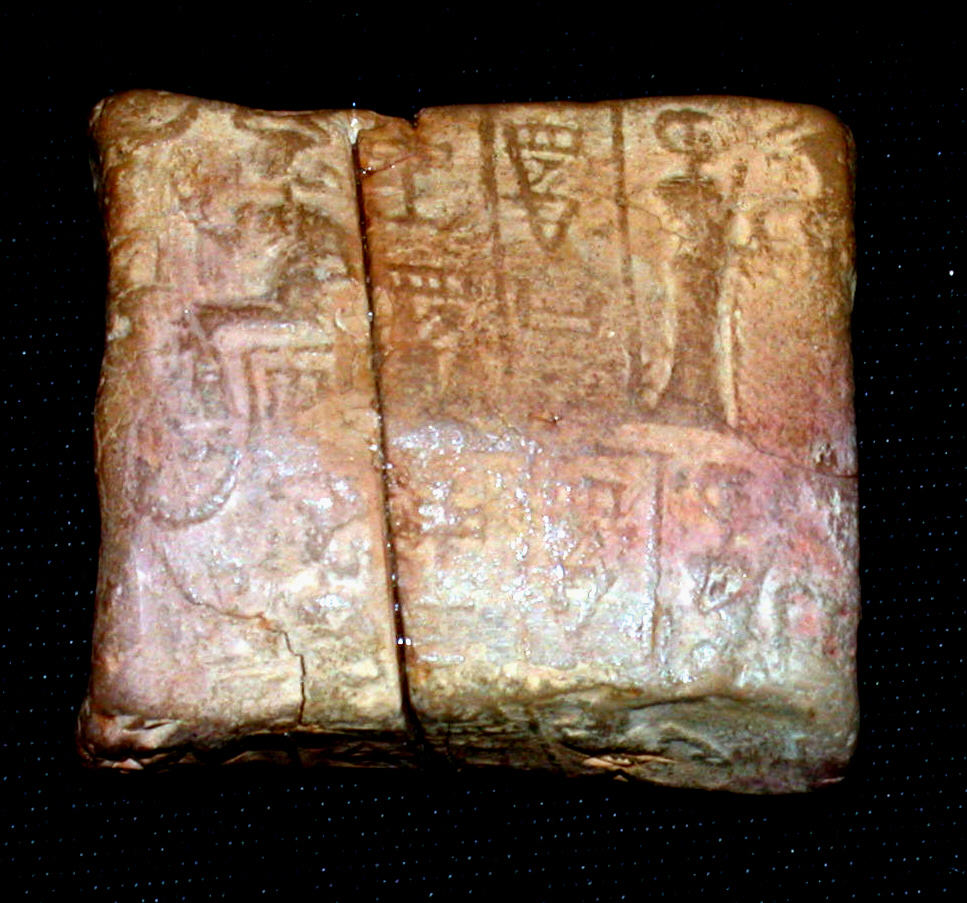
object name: cuneiform tablet case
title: Cuneiform tablet case impressed with cylinder seal, for cuneiform tablet 86.11.249a: receipt of a kid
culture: neo-sumerian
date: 2051 BCE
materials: clay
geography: mesopotamia